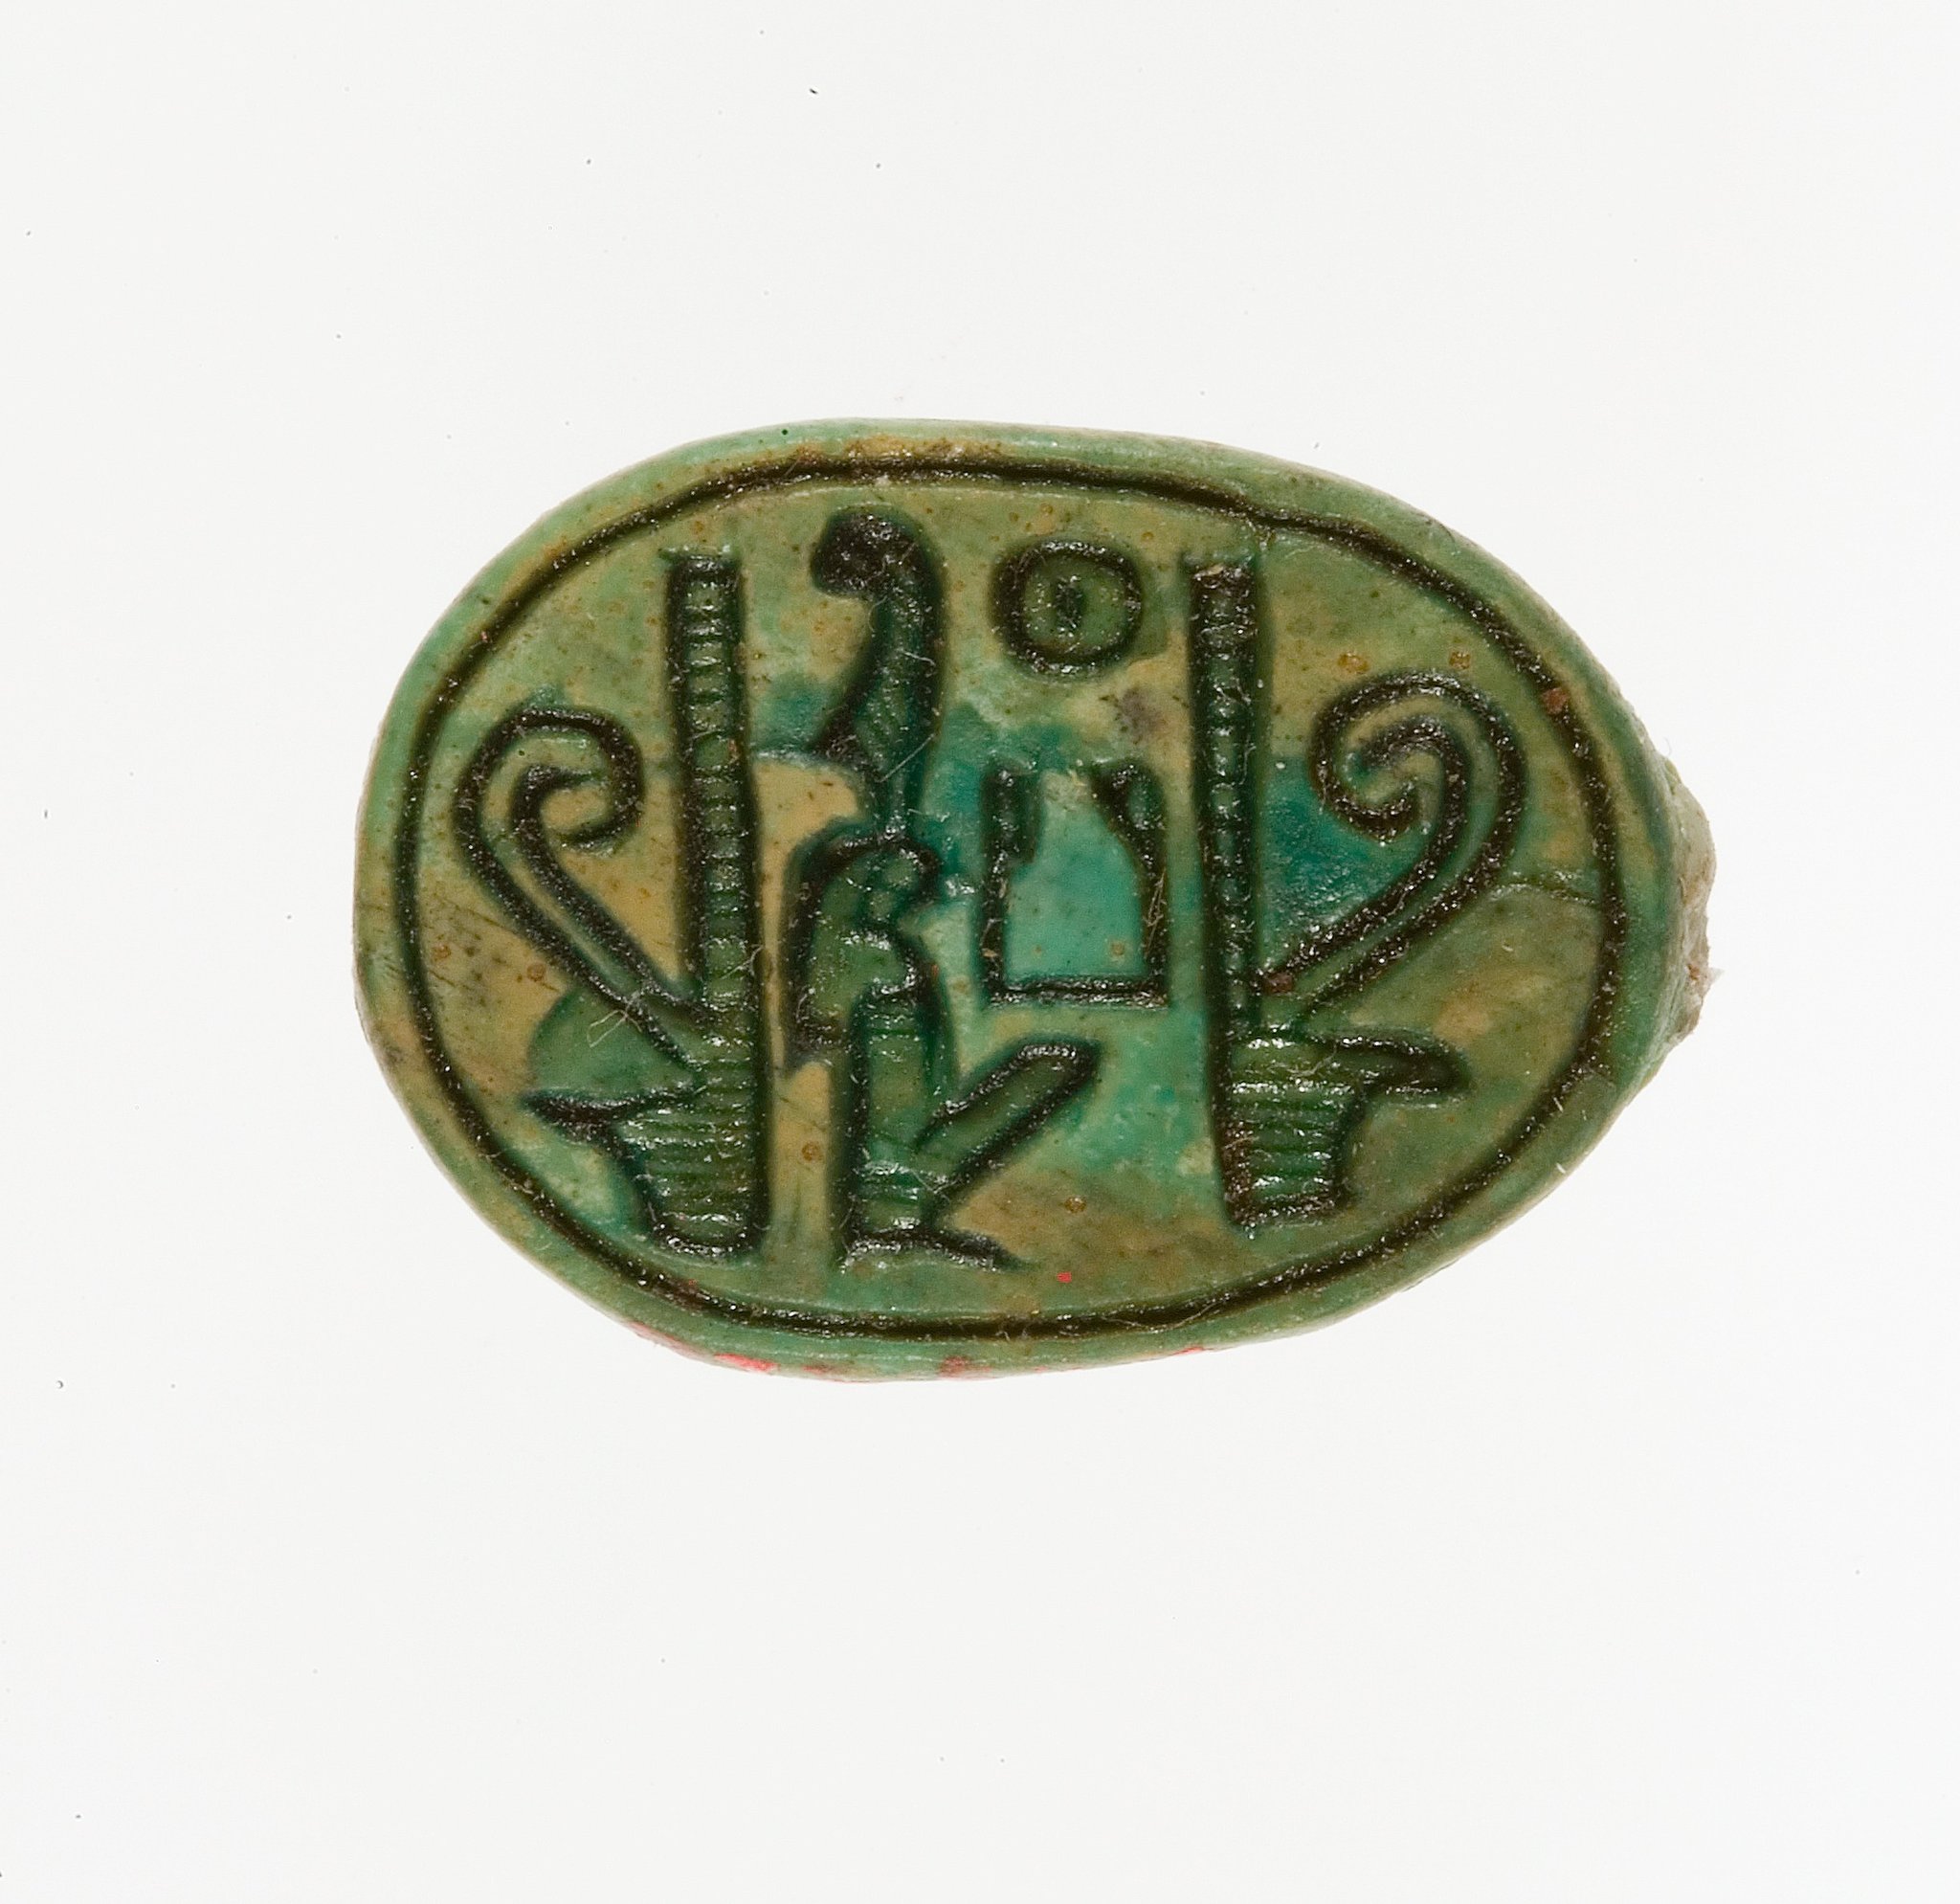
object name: scarab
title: Scarab Inscribed with the Name Maatkare (Hatshepsut) Flanked by Two Red Crowns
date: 1479-1458 BCE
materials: stone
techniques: glazing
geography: egypt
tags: hieroglyphs,scarabs